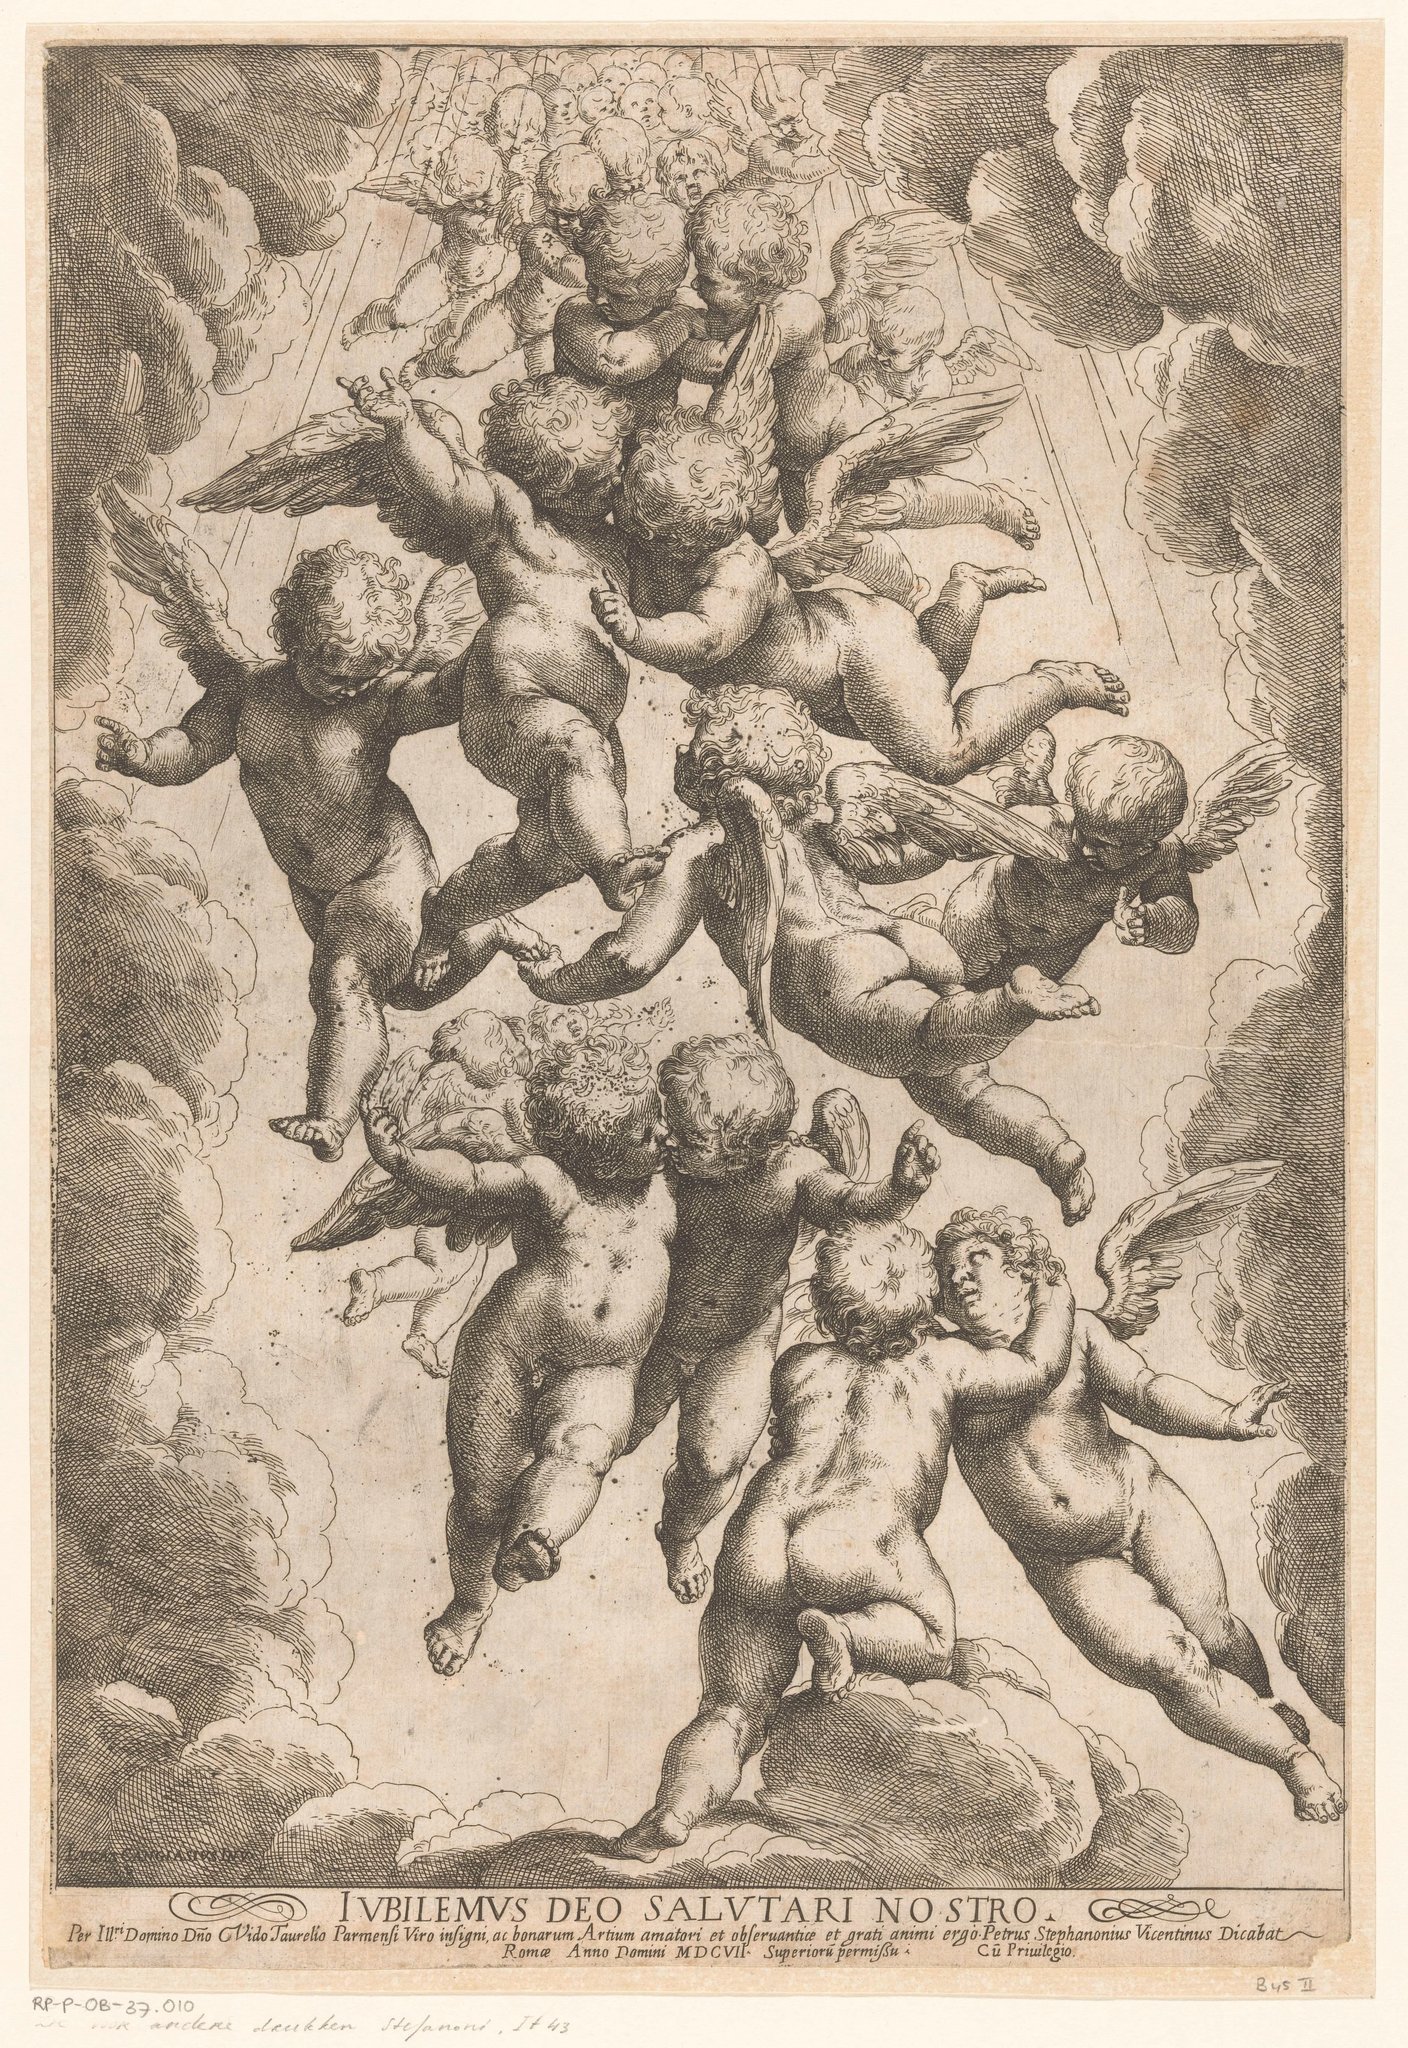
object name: print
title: Engelen in glorie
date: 1607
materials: paper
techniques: etching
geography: italy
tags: cupids: 'amores', 'amoretti', 'putti'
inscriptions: collector's mark: Lugt 2228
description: Een groep zwevende putti, omgeven door wolken. Titel in het Latijn in ondermarge.